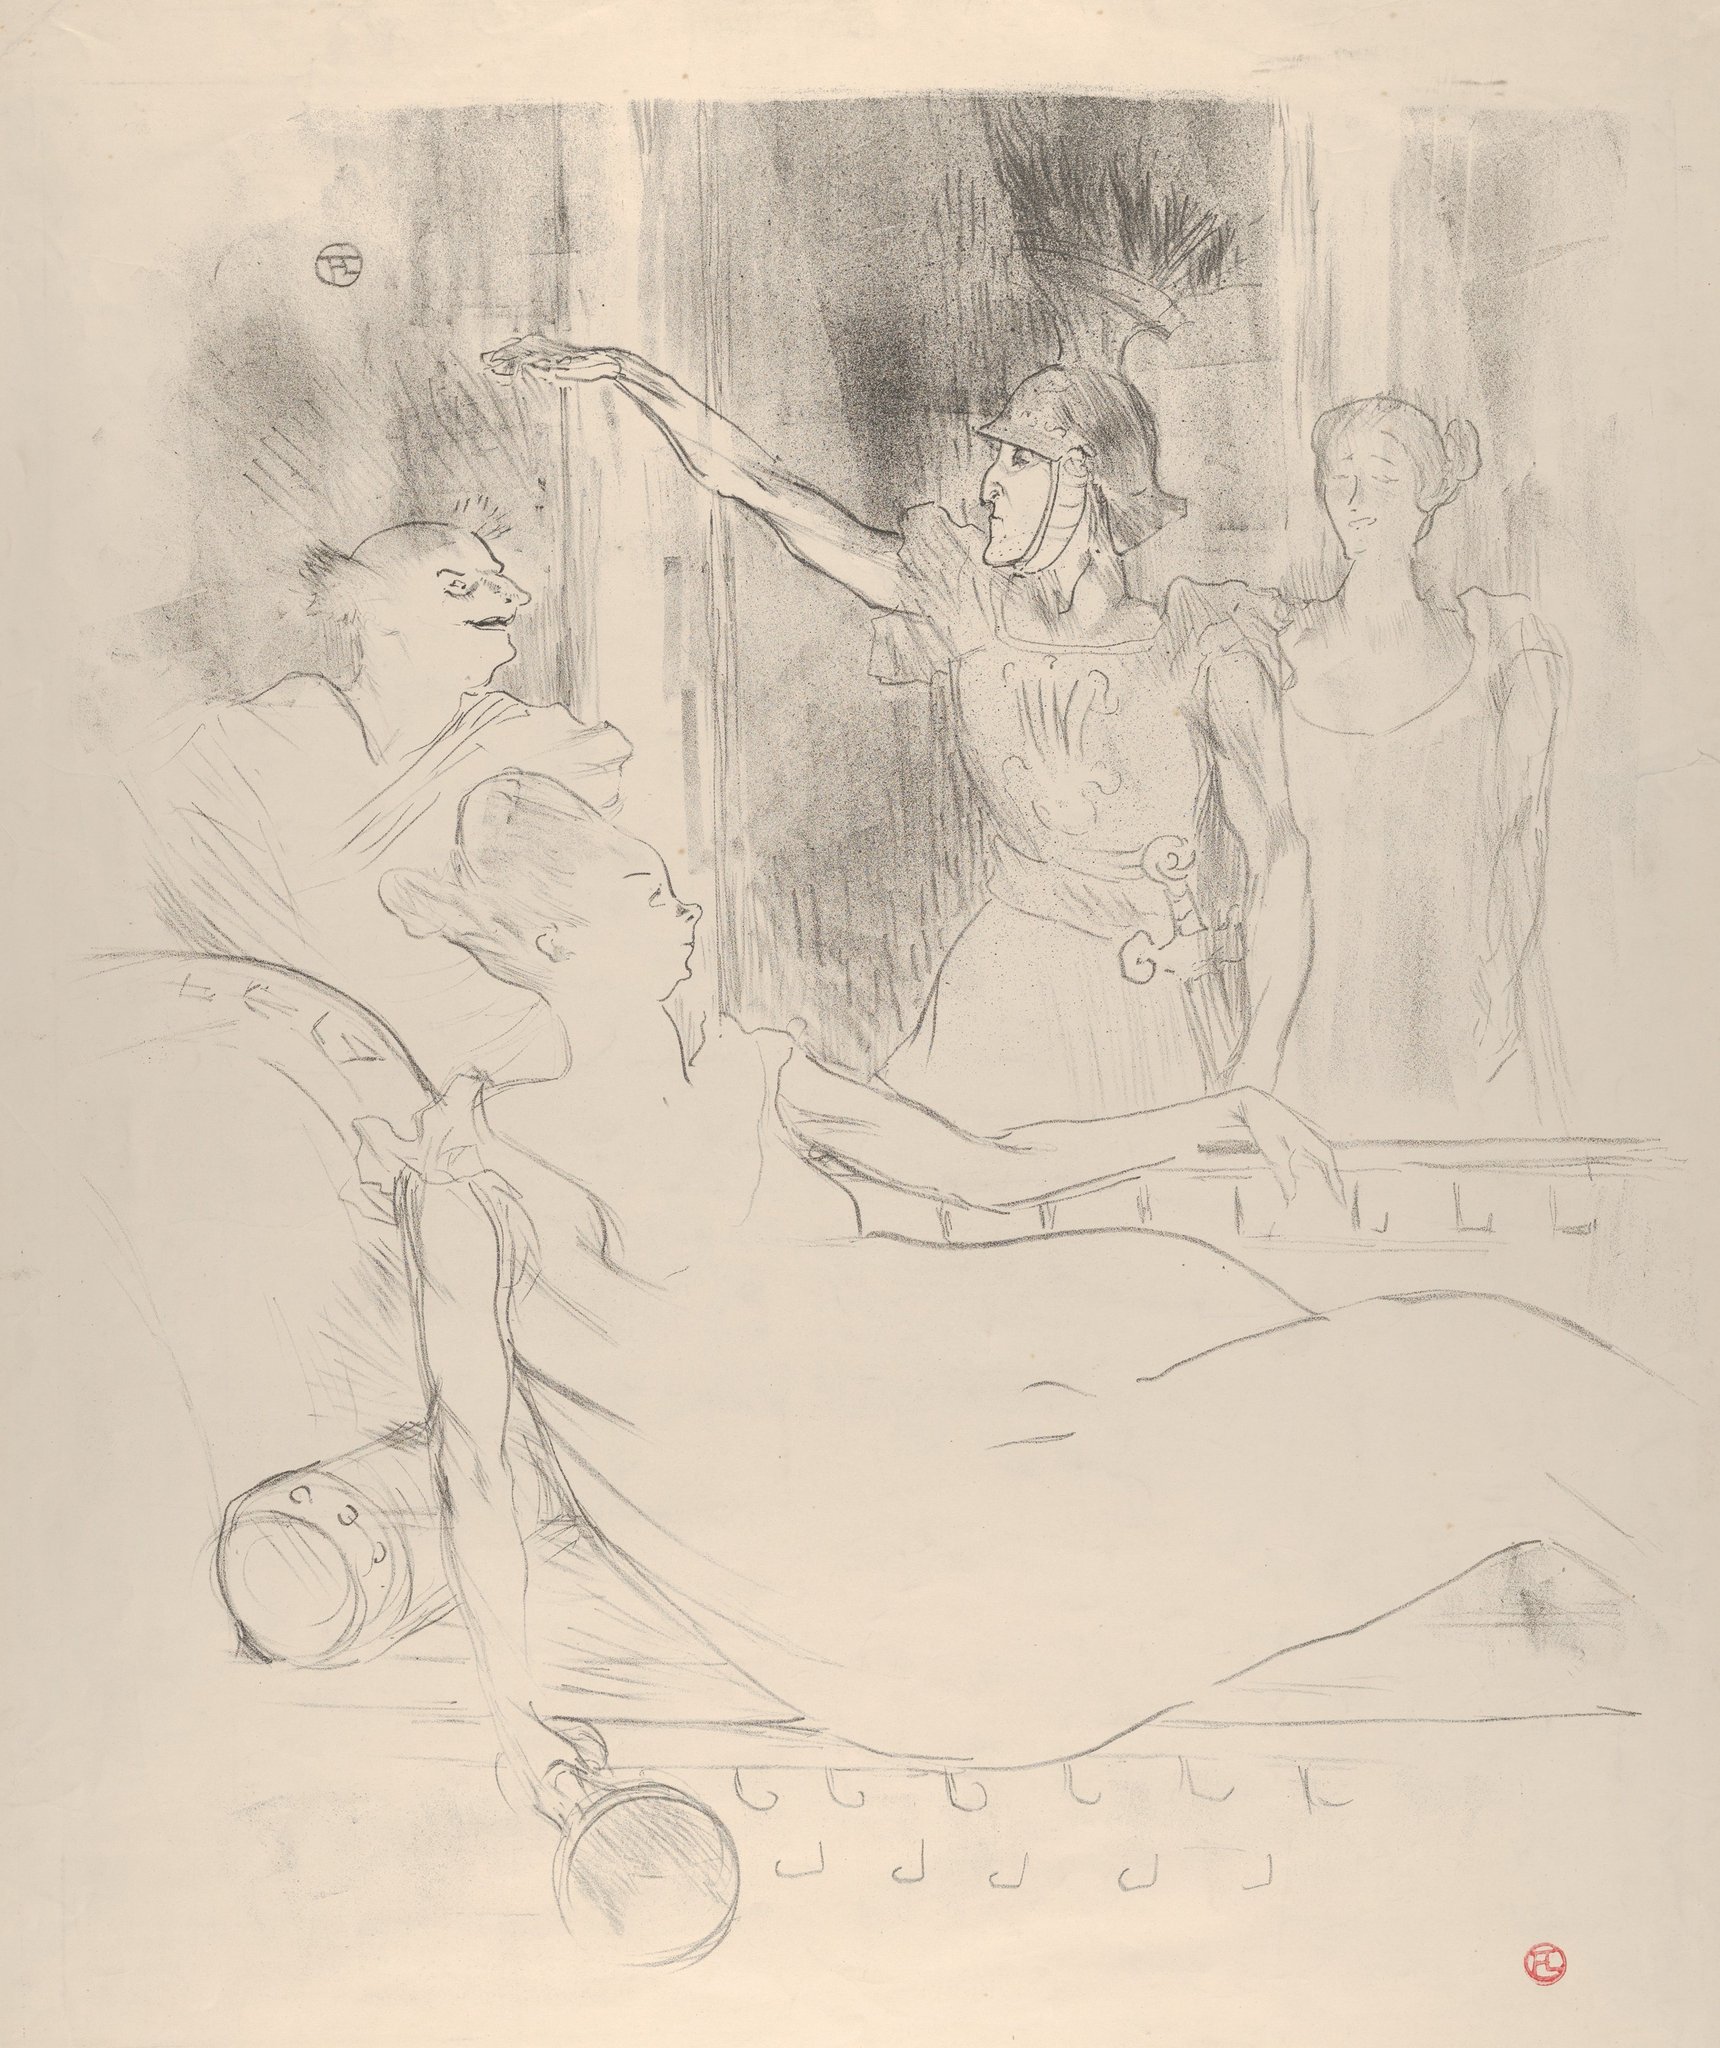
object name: print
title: A Scene from Offenbach's La Belle Hélène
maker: henri de toulouse-lautrec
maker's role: artist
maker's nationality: french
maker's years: 1864-1901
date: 1900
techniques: lithograph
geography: france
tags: soldiers,men,women